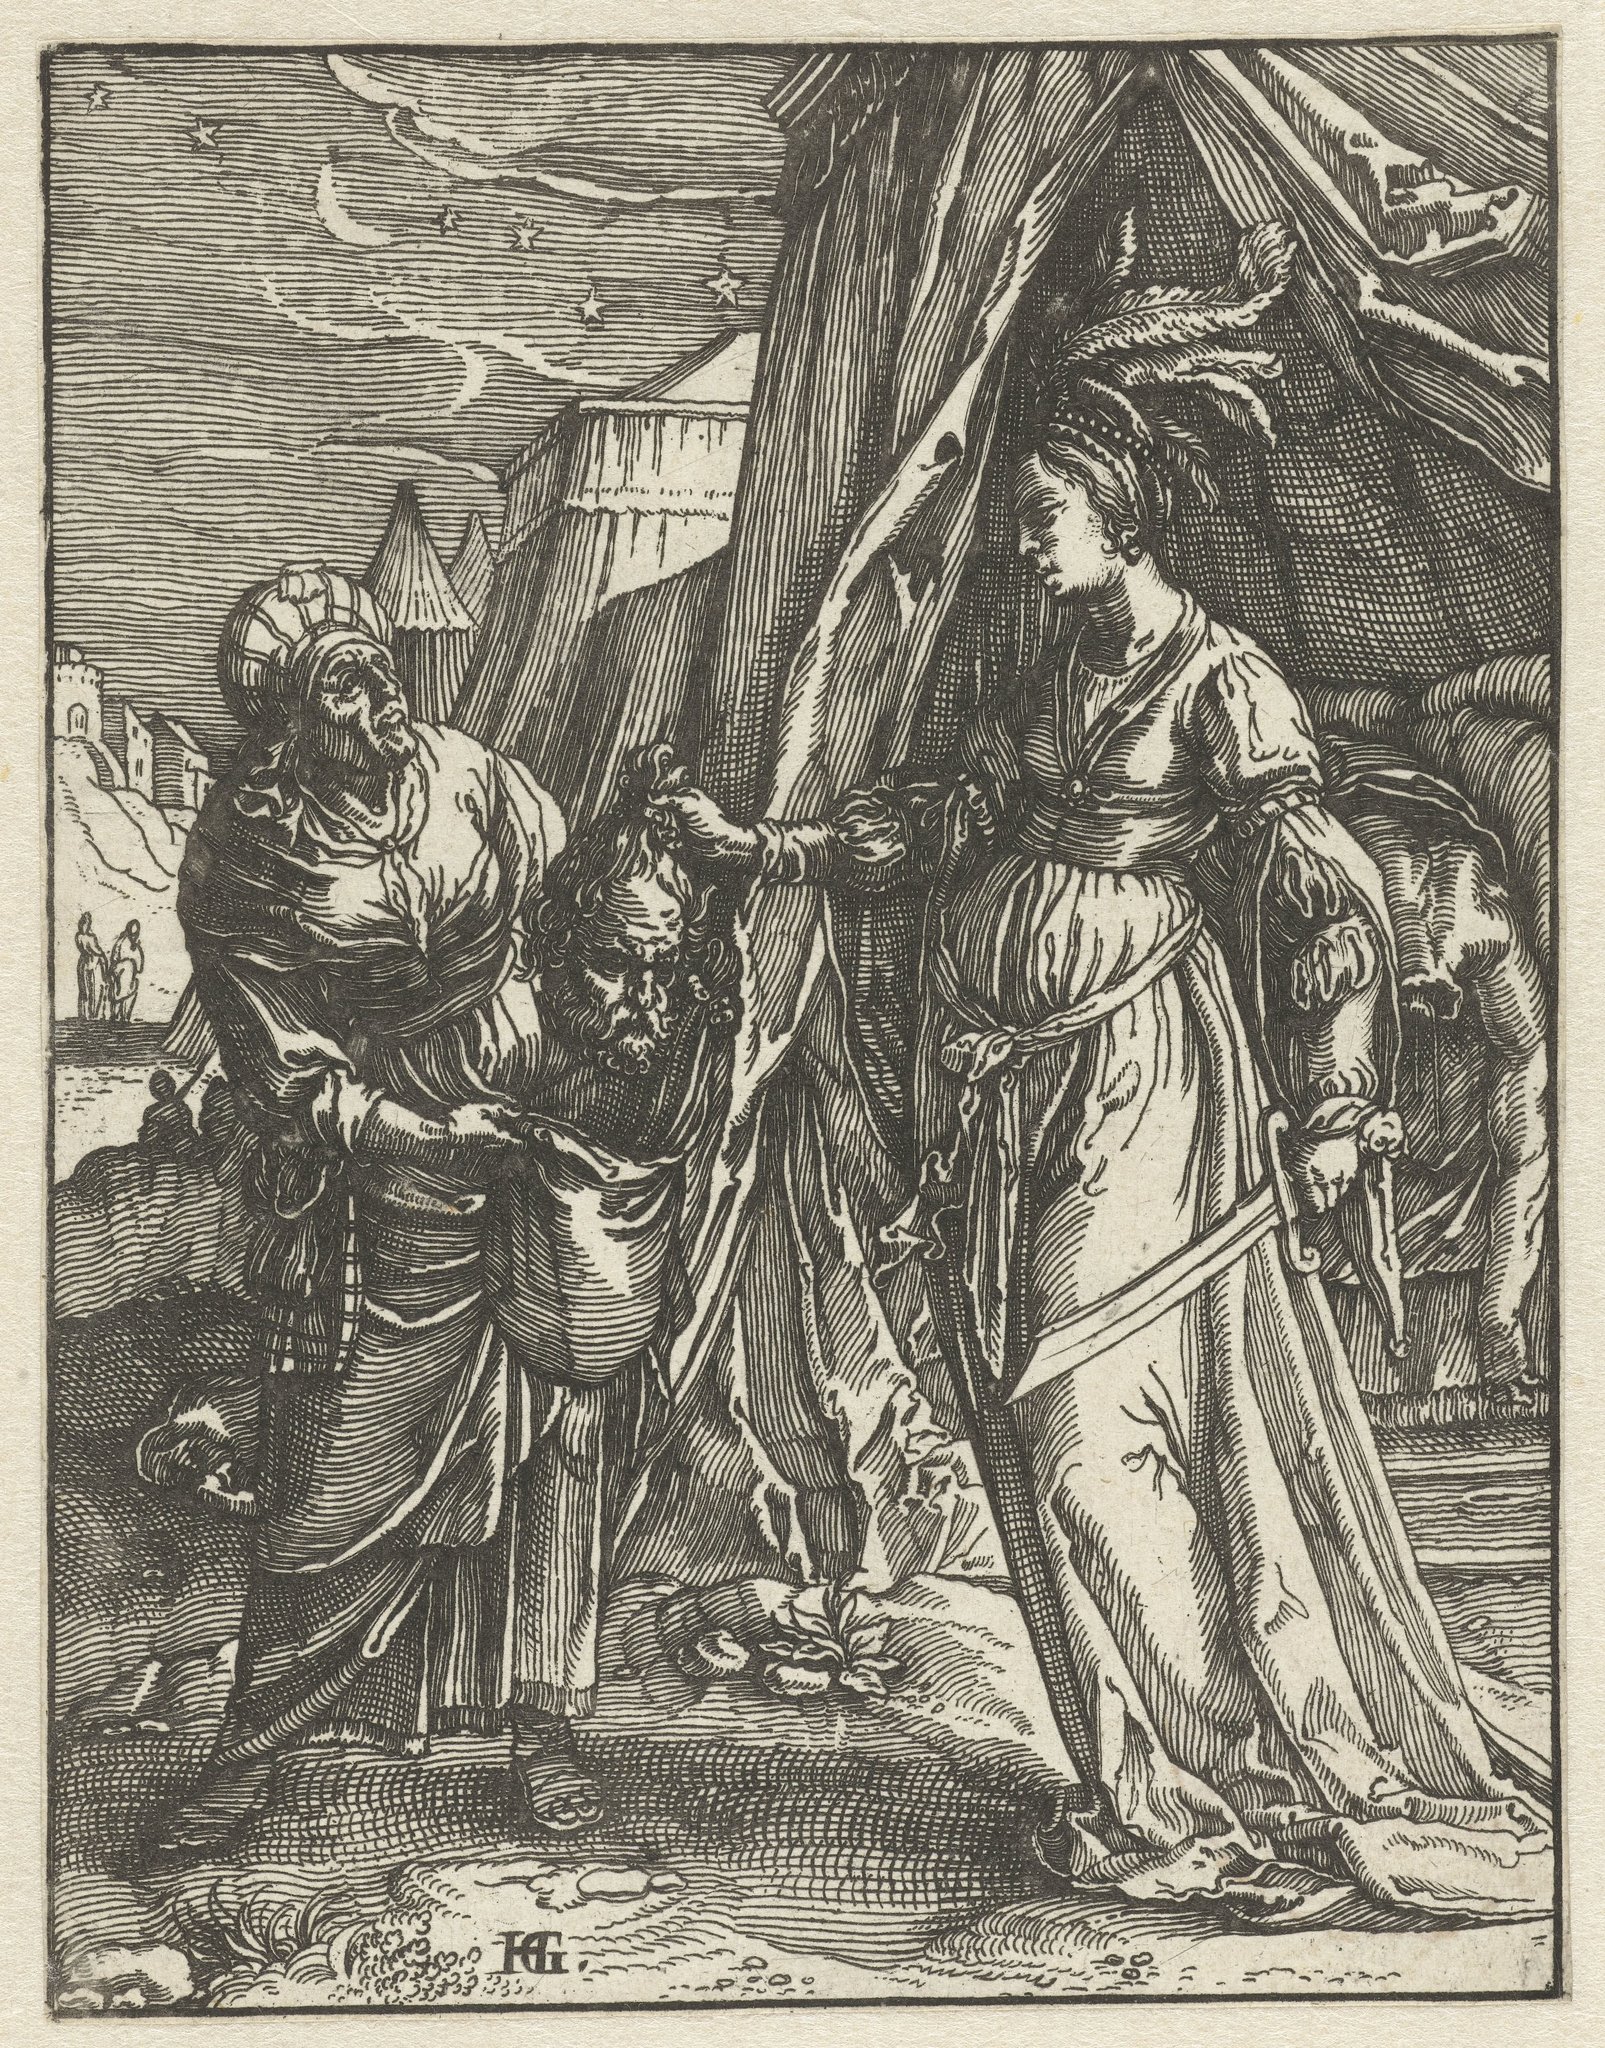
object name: print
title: Judith met het hoofd van Holofernes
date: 1600-1610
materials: paper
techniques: etching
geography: amsterdam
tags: judith and holofernes (judith 8-16)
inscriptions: collector's mark: Lugt 240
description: Judith stopt het hoofd van Holofernes in de zak die haar dienstmaagd voor haar open houdt. Rechts achter hen, in zijn tent, het verminkte lijf van Holofernes.